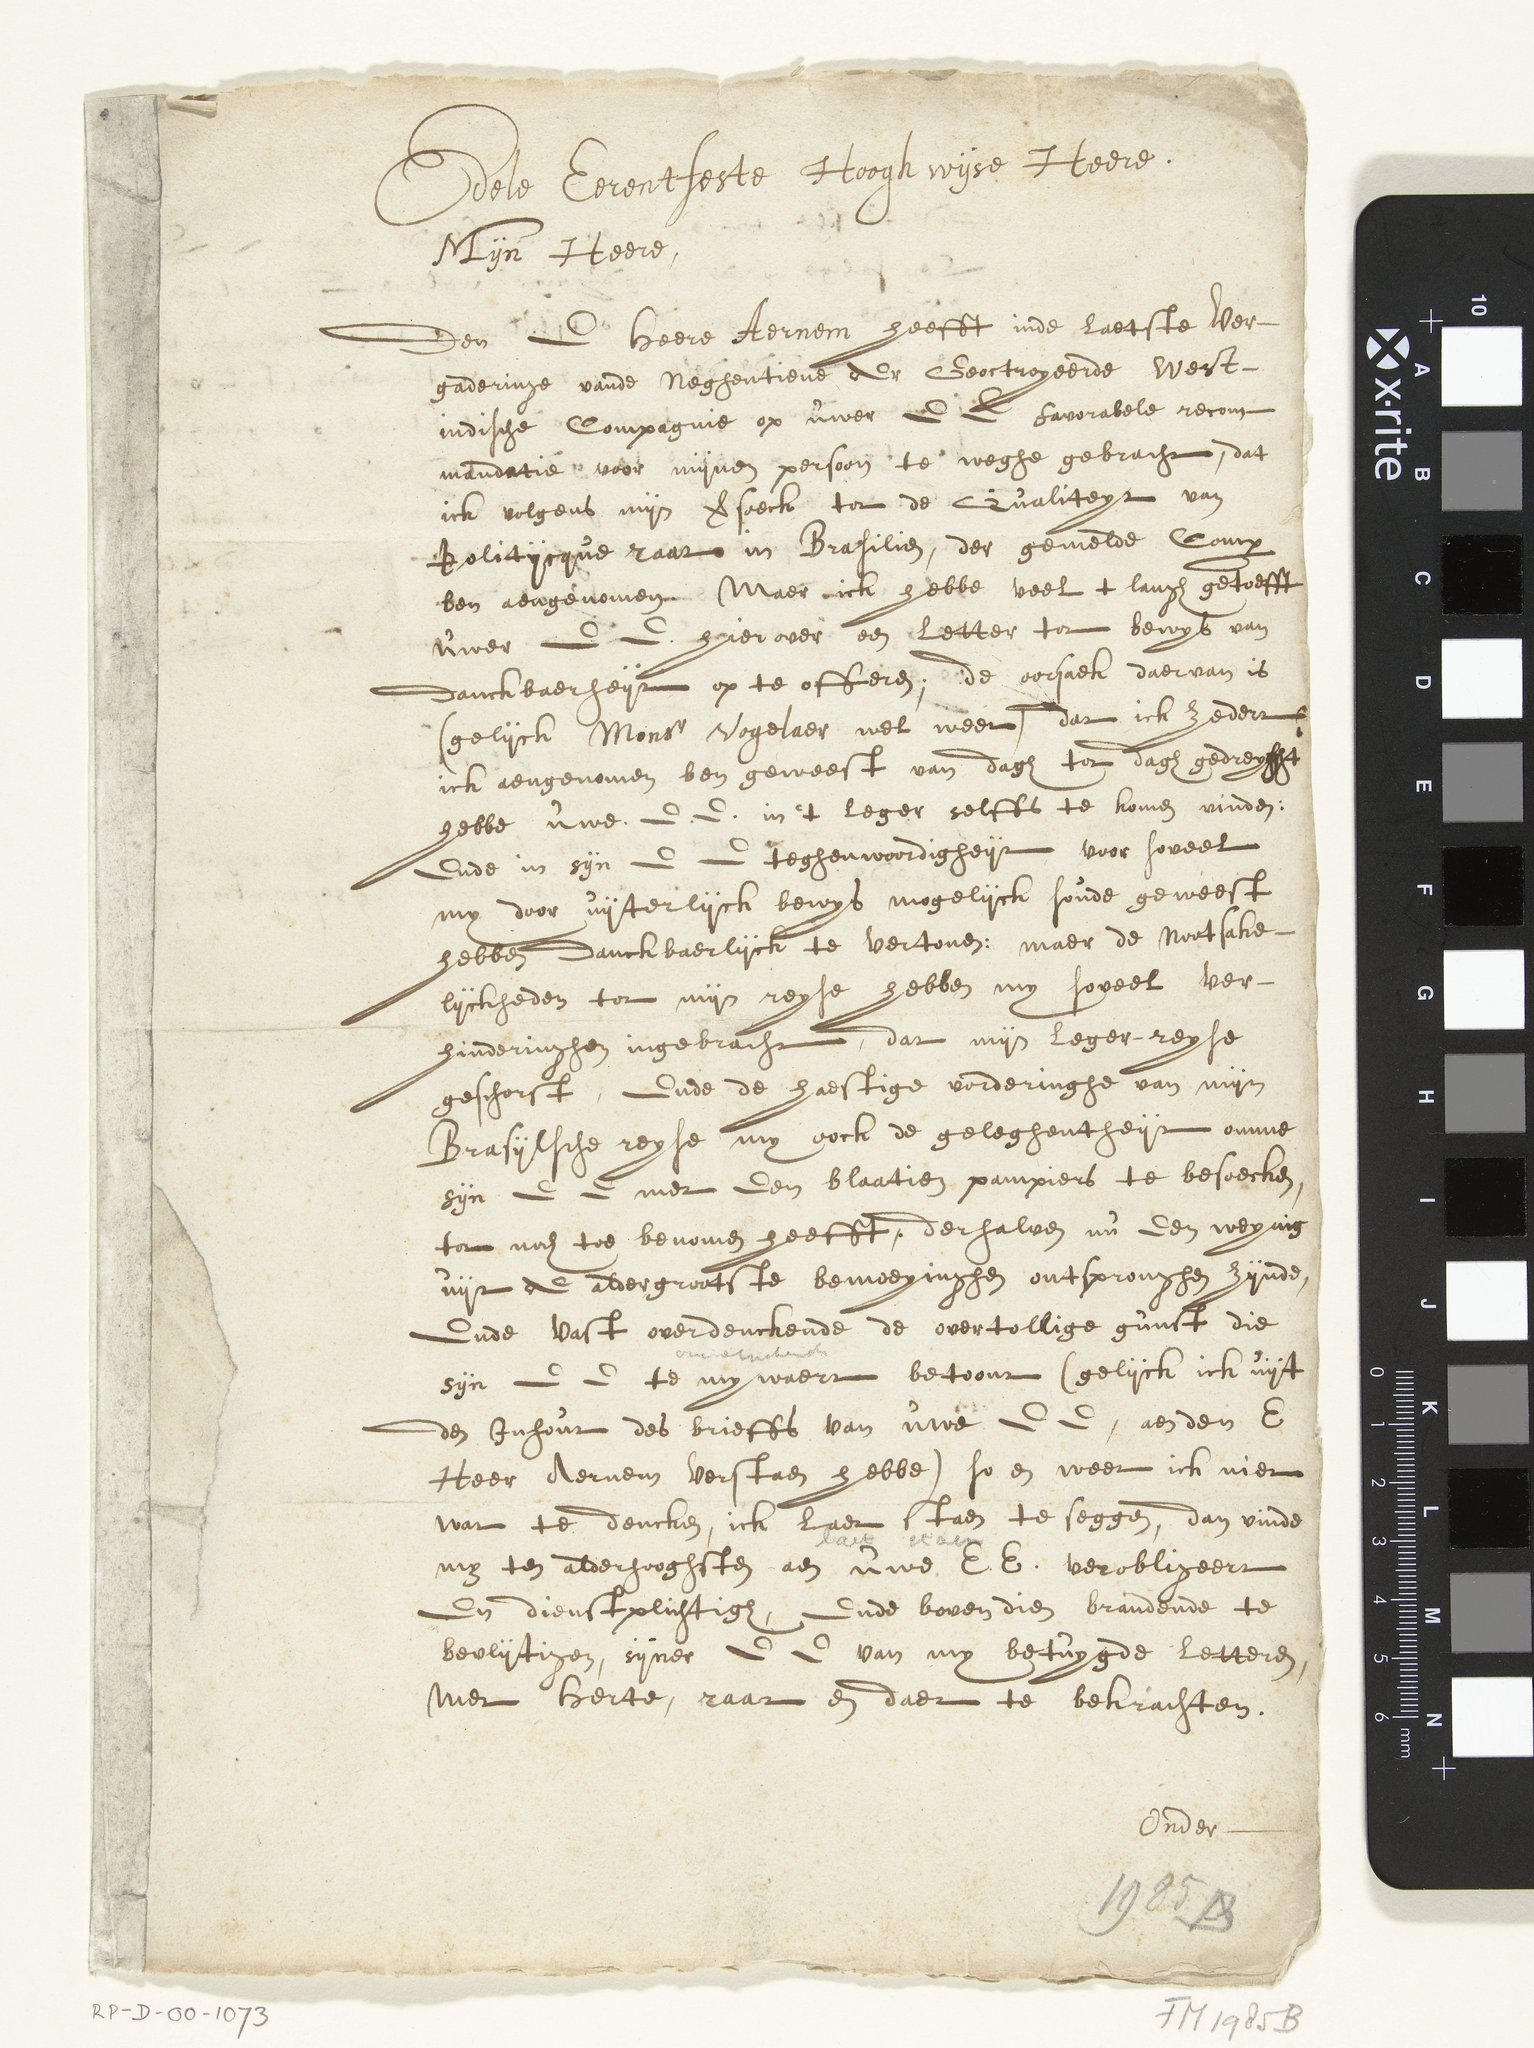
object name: letter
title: Brief van E. Herckmans aan Constantijn Huygens, 1635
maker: elias herckmans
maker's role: schrijver, zeeman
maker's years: 1596-1644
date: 1635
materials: paper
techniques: writing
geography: texel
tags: the hague, constantijn huygens (i)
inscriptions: date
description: Brief van de dichter Elias Herckmans aan Constantijn Huygens, geschreven aan boord van het schip Den Hollandschen Tuijn, bij Texel liggende klaar om te vertrekken voor een reis naar Brazilië, 29 september 1635. Twee aan elkaar geplakte bladen papier, het eerste blad op beide zijde beschreven, op het tweede blad de naam van de geadresseerde en een zegel. Bij de brief ook een moderne transcriptie.